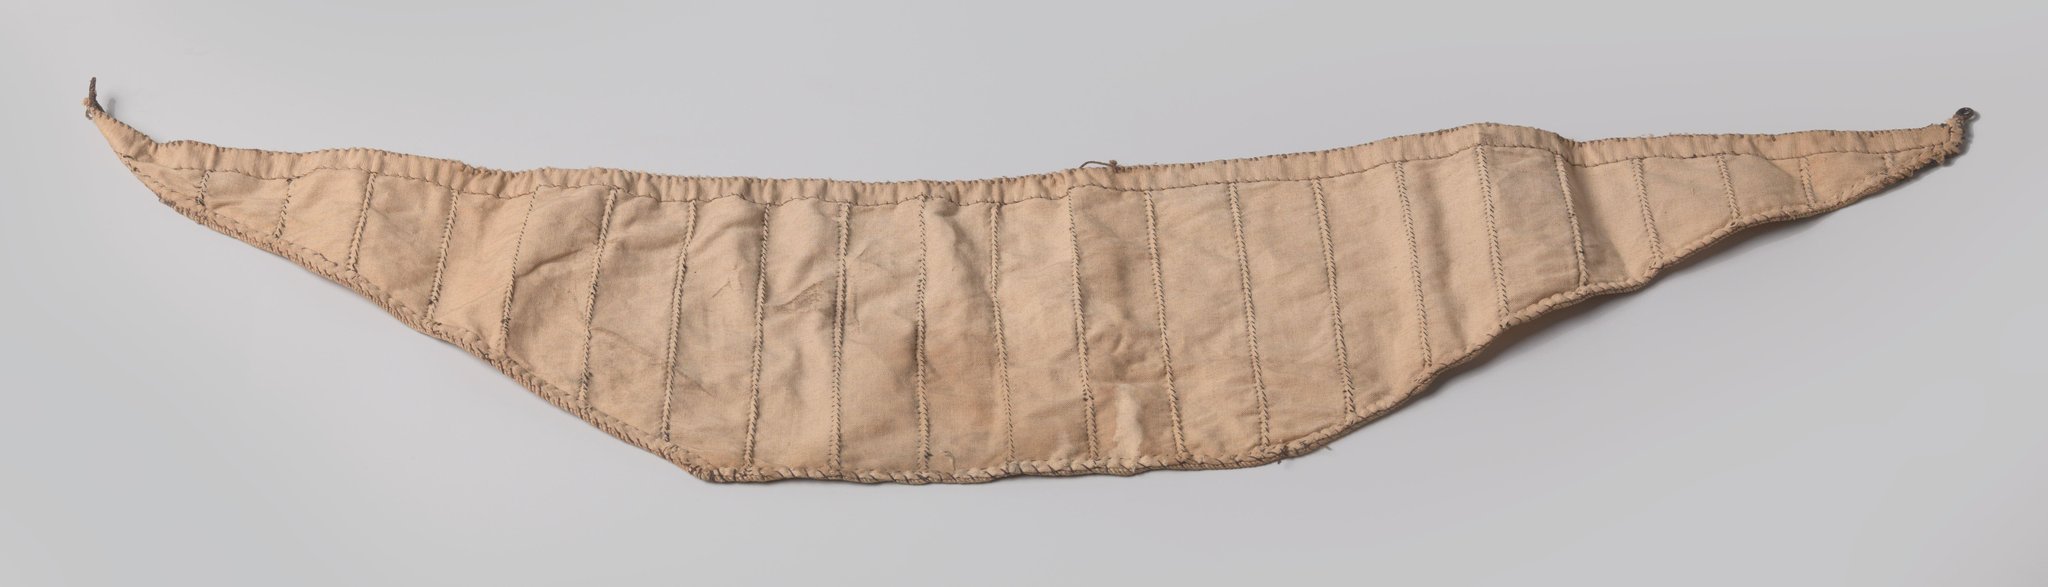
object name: sail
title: Zeil, behorend bij een model van een oorlogskotter van 18 stukken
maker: Anonymous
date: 1775-1805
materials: linen, fiber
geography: netherlands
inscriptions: inscription: ‘VLIEG’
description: Dit model behoorde in 1807 tot de privé-collectie van J.P. Asmus en stond in de modellenzaal op de Marinewerf te Amsterdam. Volgens de beschrijving had het toen nog een sloepje in de davits aan het hek hangen, en een zonnetent over geheel het dek gespannen. Asmus omschreef het model als een voorbeeld van de snelste Engelse kotters.